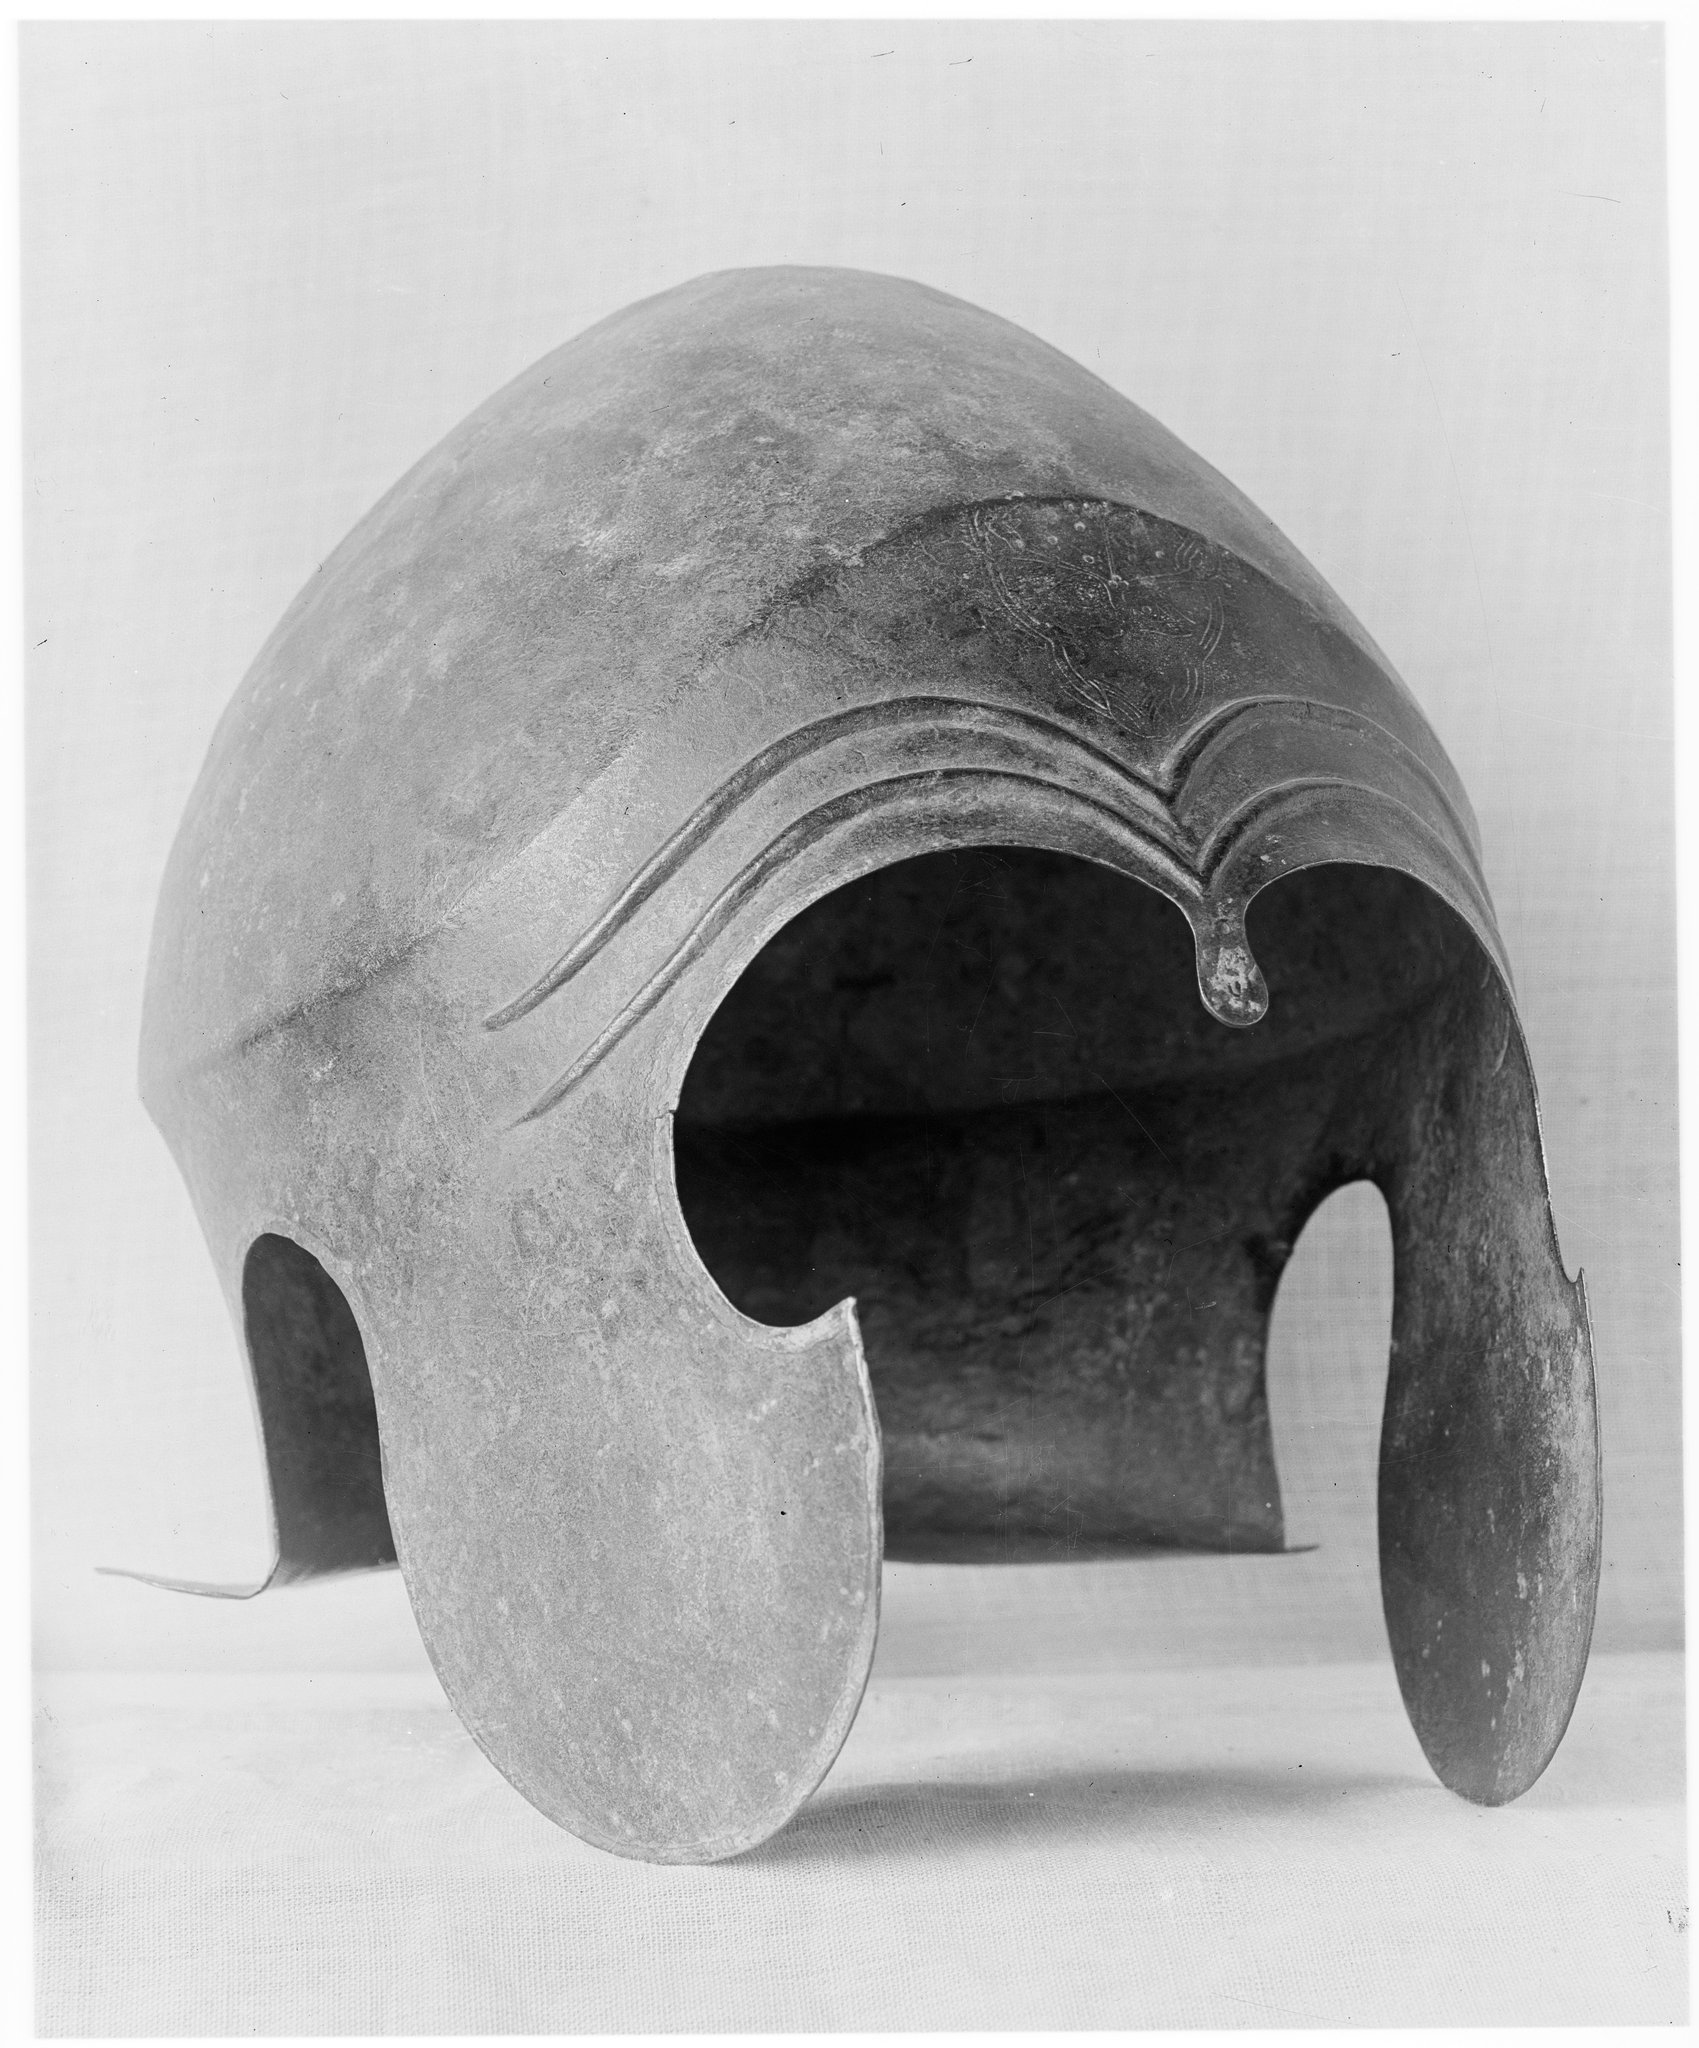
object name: helmet of chalcidian type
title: Bronze helmet of Chalcidian type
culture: greek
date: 550-501 BCE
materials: bronze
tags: helmets